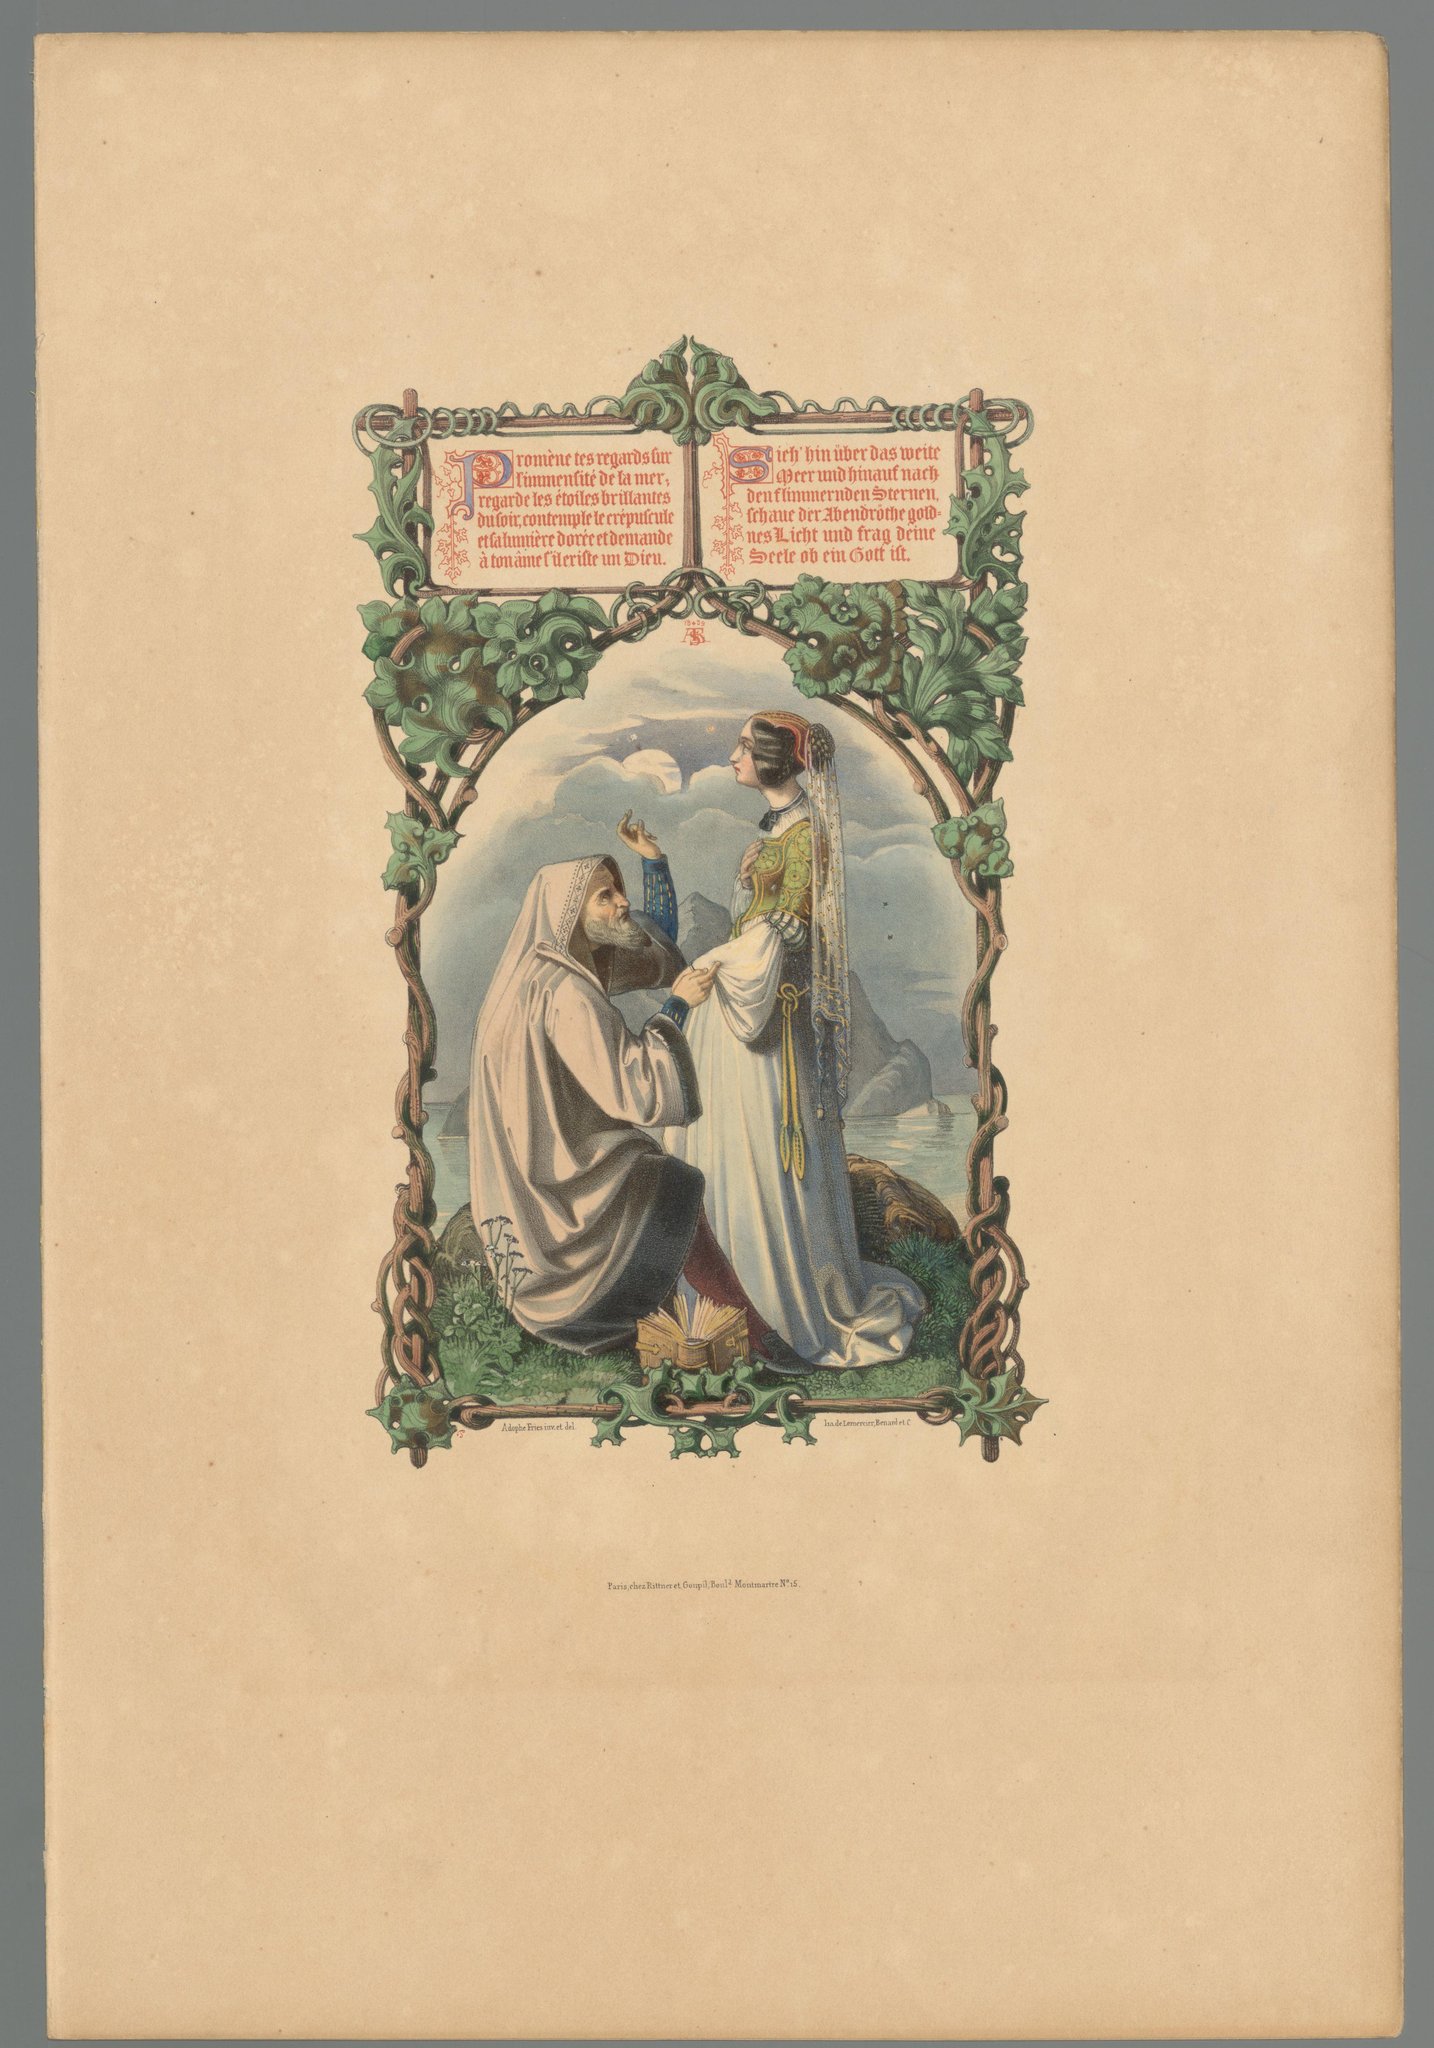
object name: print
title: Vrouw staat voor een oude man die naar de lucht wijst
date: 1839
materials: paper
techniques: hand coloring, lithograph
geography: paris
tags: adult woman, old man, firmament, sky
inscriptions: collector's mark: Lugt 2228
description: Prent maakt deel uit van een serie met religieuze scènes. Over deze serie is verder niets bekend. Mogelijk is het een aanvulling op de eerder uitgegeven serie 'Paroles de l'âme' van Adolf Fries in 1837.